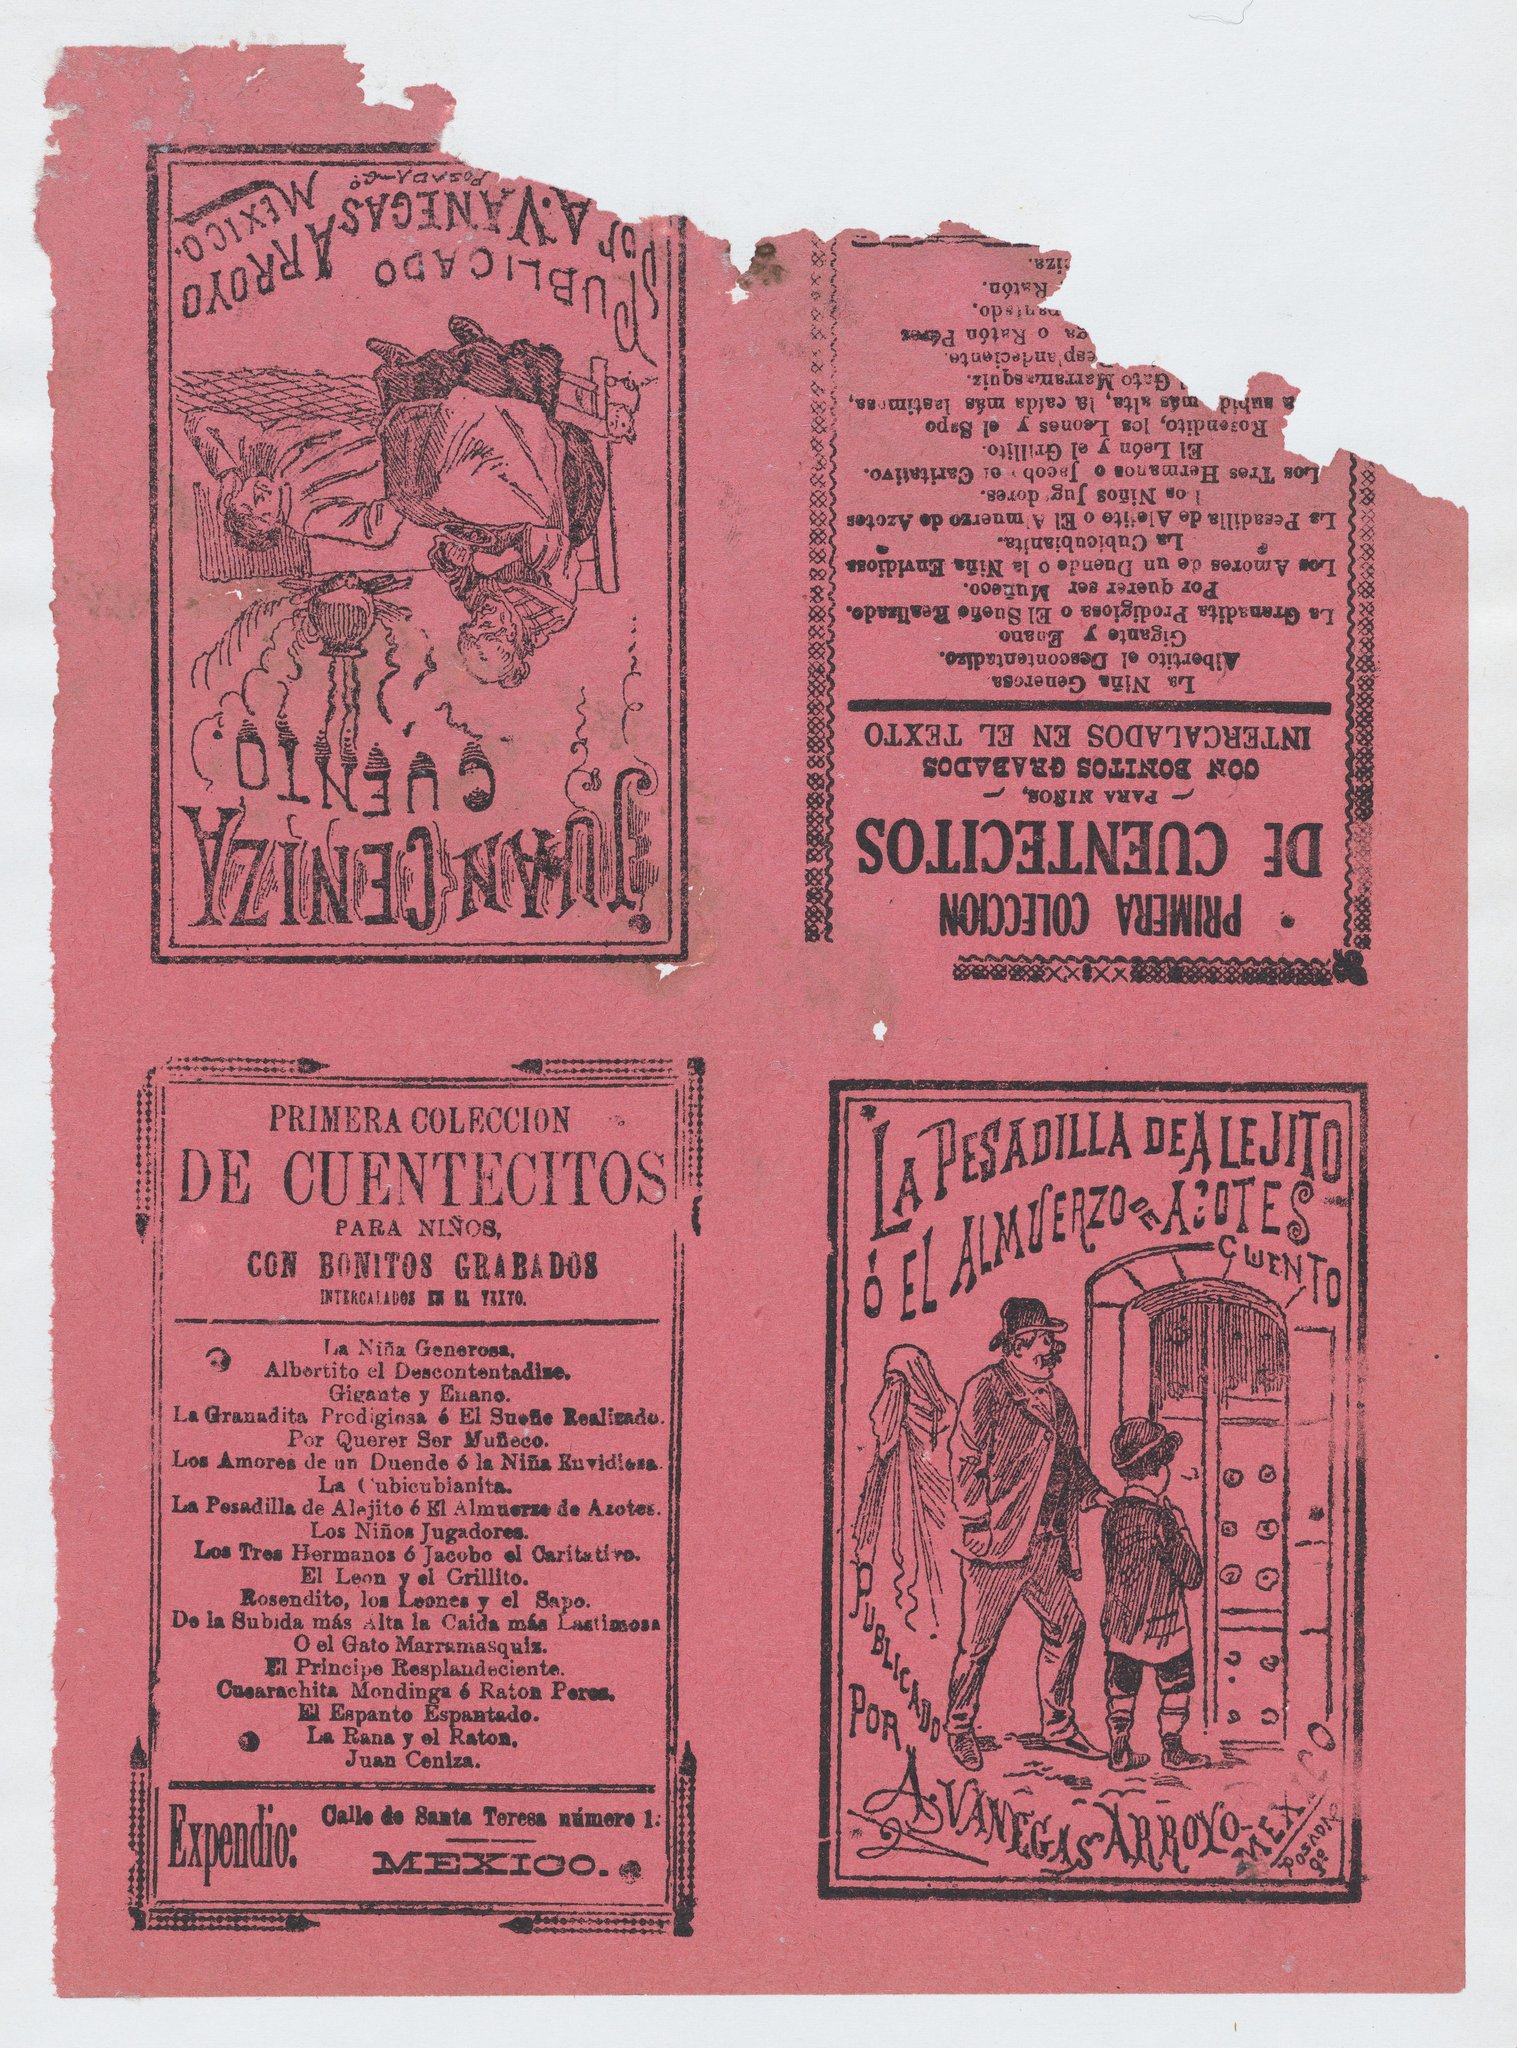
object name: print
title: Covers for 'La Pesadilla de Alejito o el Almuerzo de Acotes' and 'Juan Ceniza'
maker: josé guadalupe posada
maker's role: artist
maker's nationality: mexican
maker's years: 1852-1913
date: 1890-1910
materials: paper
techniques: letterpress, lithography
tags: boys,men,women